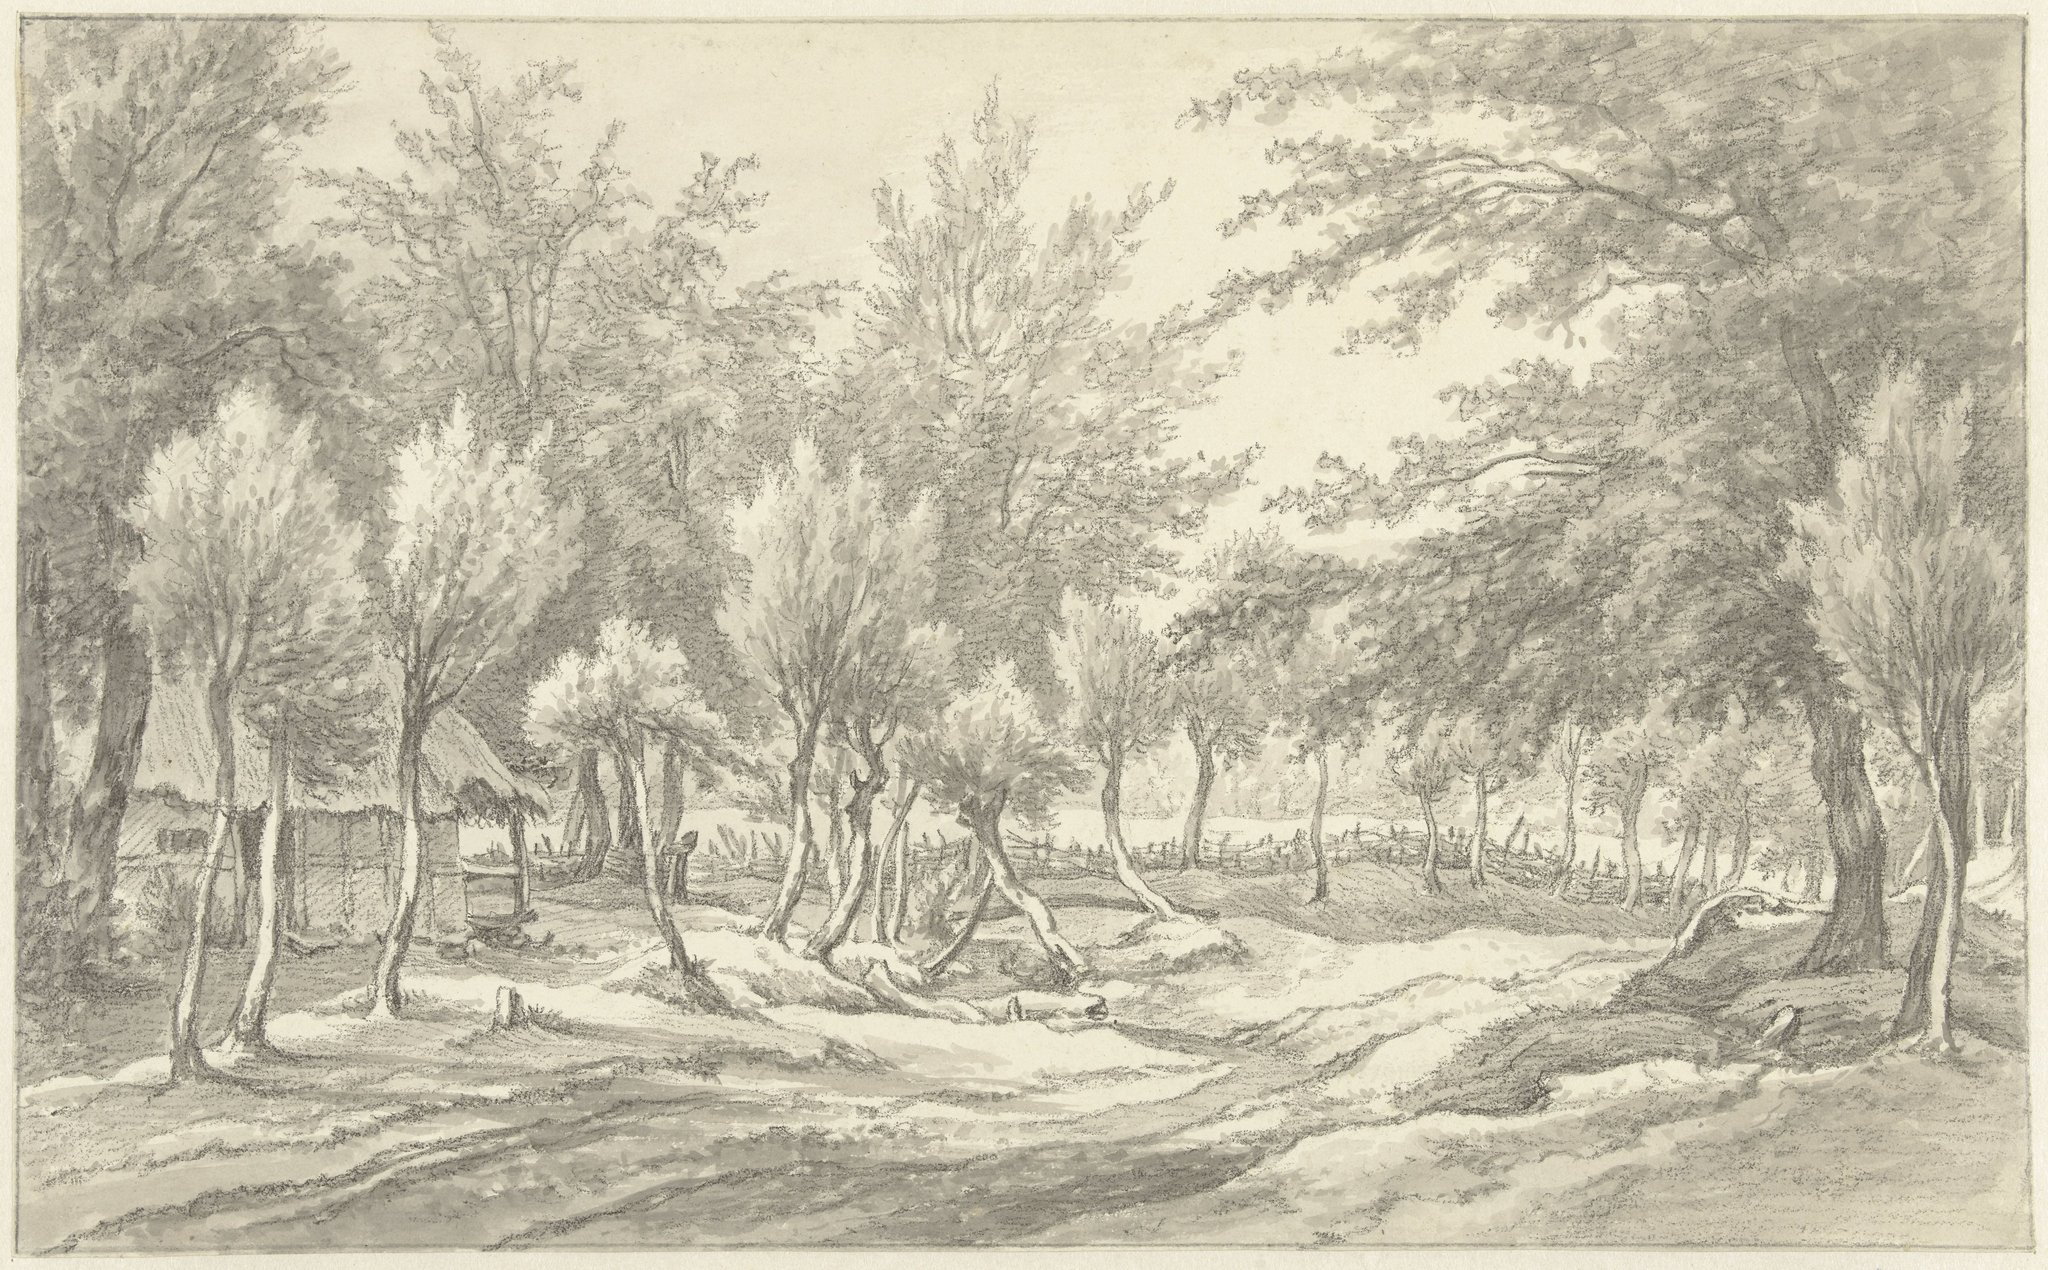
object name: drawing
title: Gezicht te Tine in het Braamse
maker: egbert van drielst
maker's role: draughtsman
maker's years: 1745-1818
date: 1755-1818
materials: chalk, paper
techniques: brush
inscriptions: inscription: ‘Tine in het Braamse’